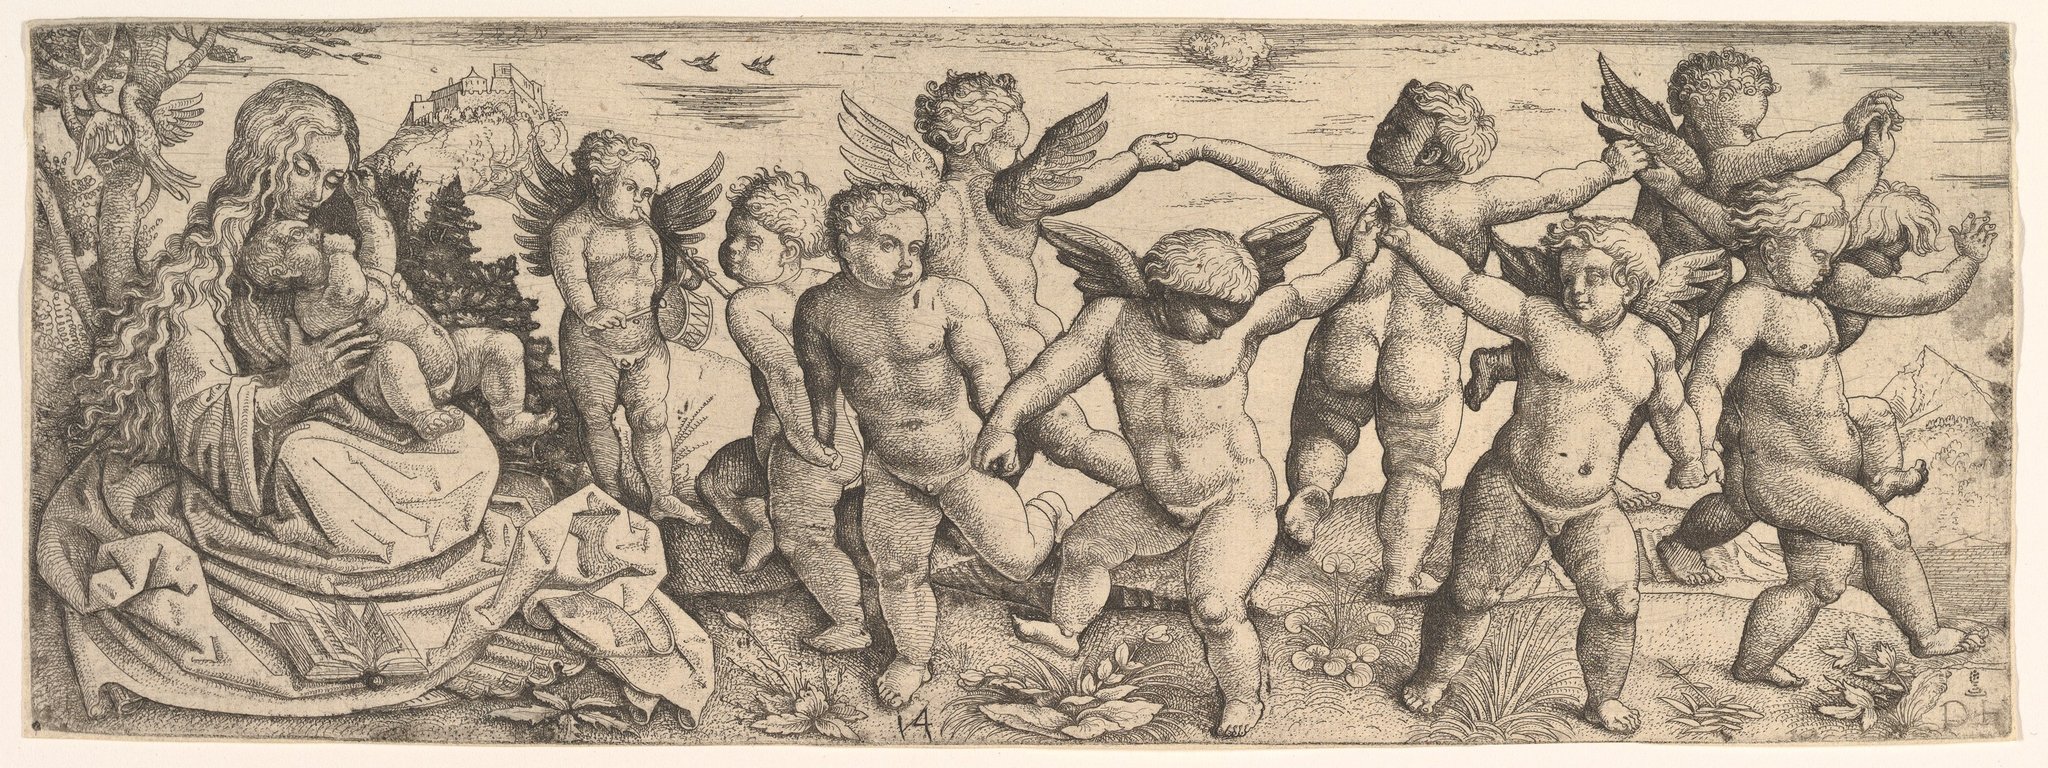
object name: print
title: Virgin and Child with Angels Dancing in a Landscape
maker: daniel hopfer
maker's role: artist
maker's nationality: german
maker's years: 1470-1536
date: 1530-1539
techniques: etching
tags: dancing,angels,madonna and child